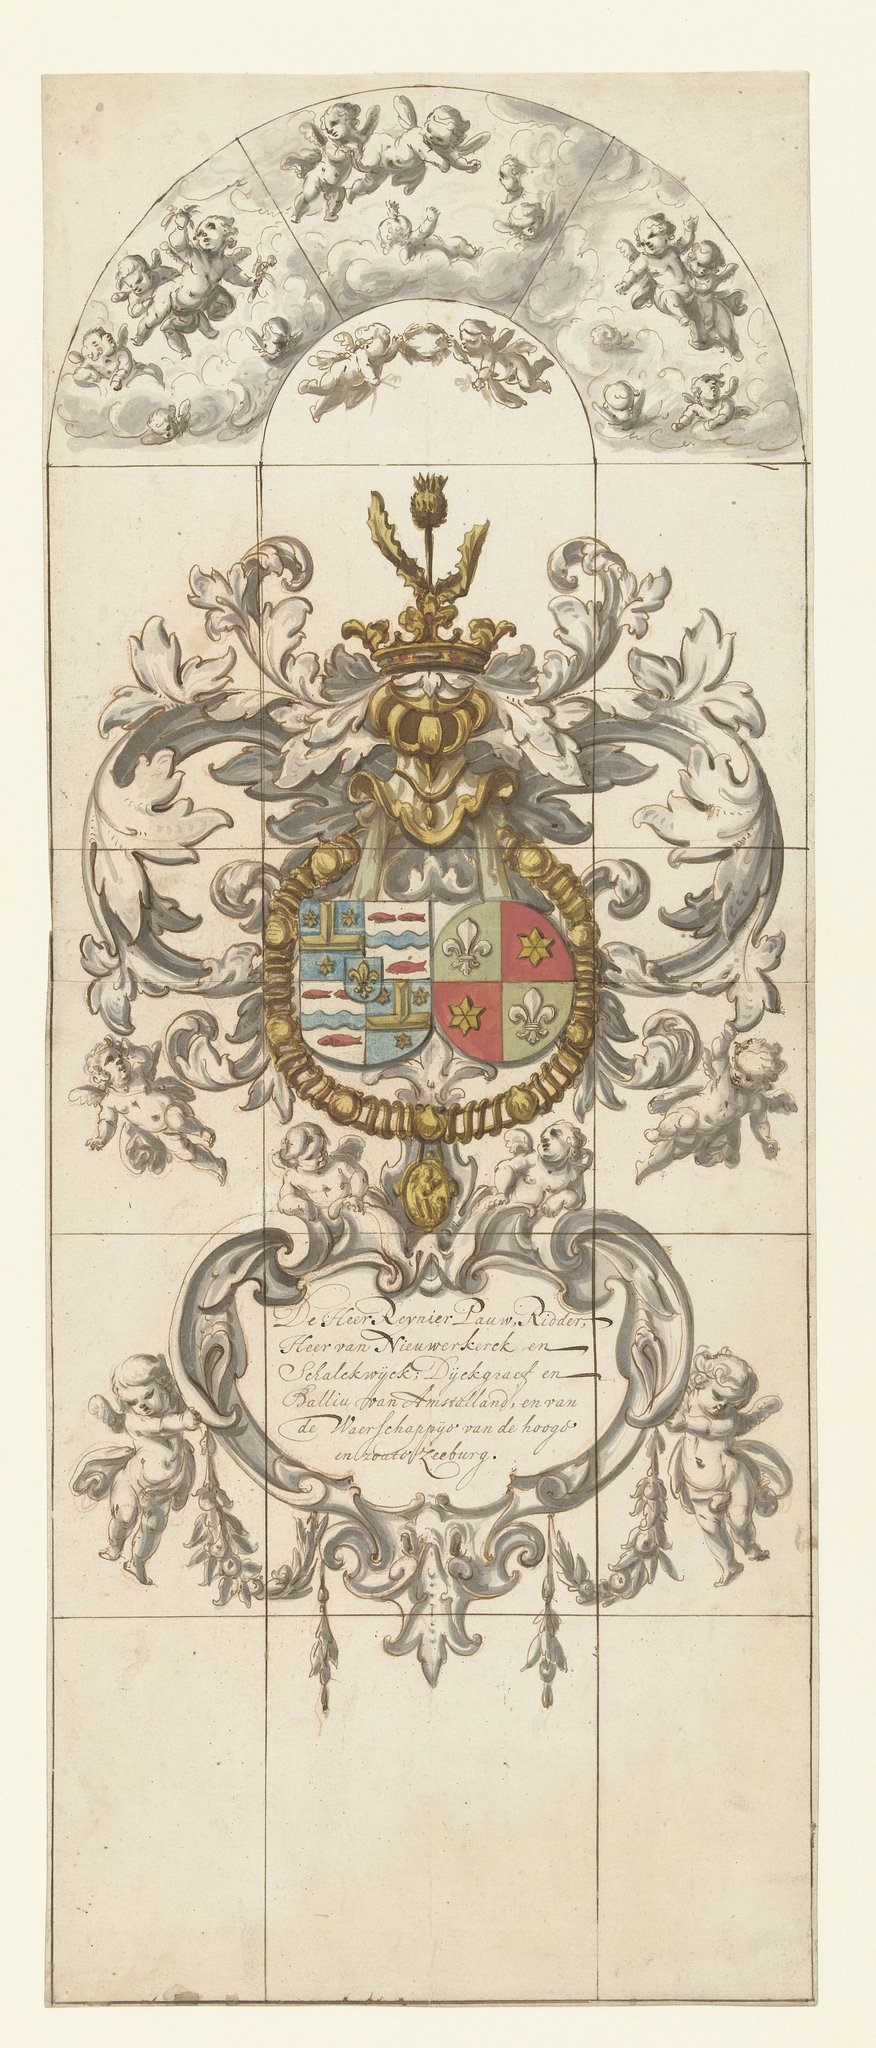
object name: drawing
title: Ontwerp voor glasraam 13 geschonken door Reinier Pauw, dijkgraaf en baljuw van het hoogheemraadschap Amstelland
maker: pieter jansz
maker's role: draughtsman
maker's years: 1602-1672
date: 1665-1667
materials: ink, paper, pencil, watercolor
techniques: brush, pen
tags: armorial bearing, heraldry - aa - female, armorial bearing, heraldry